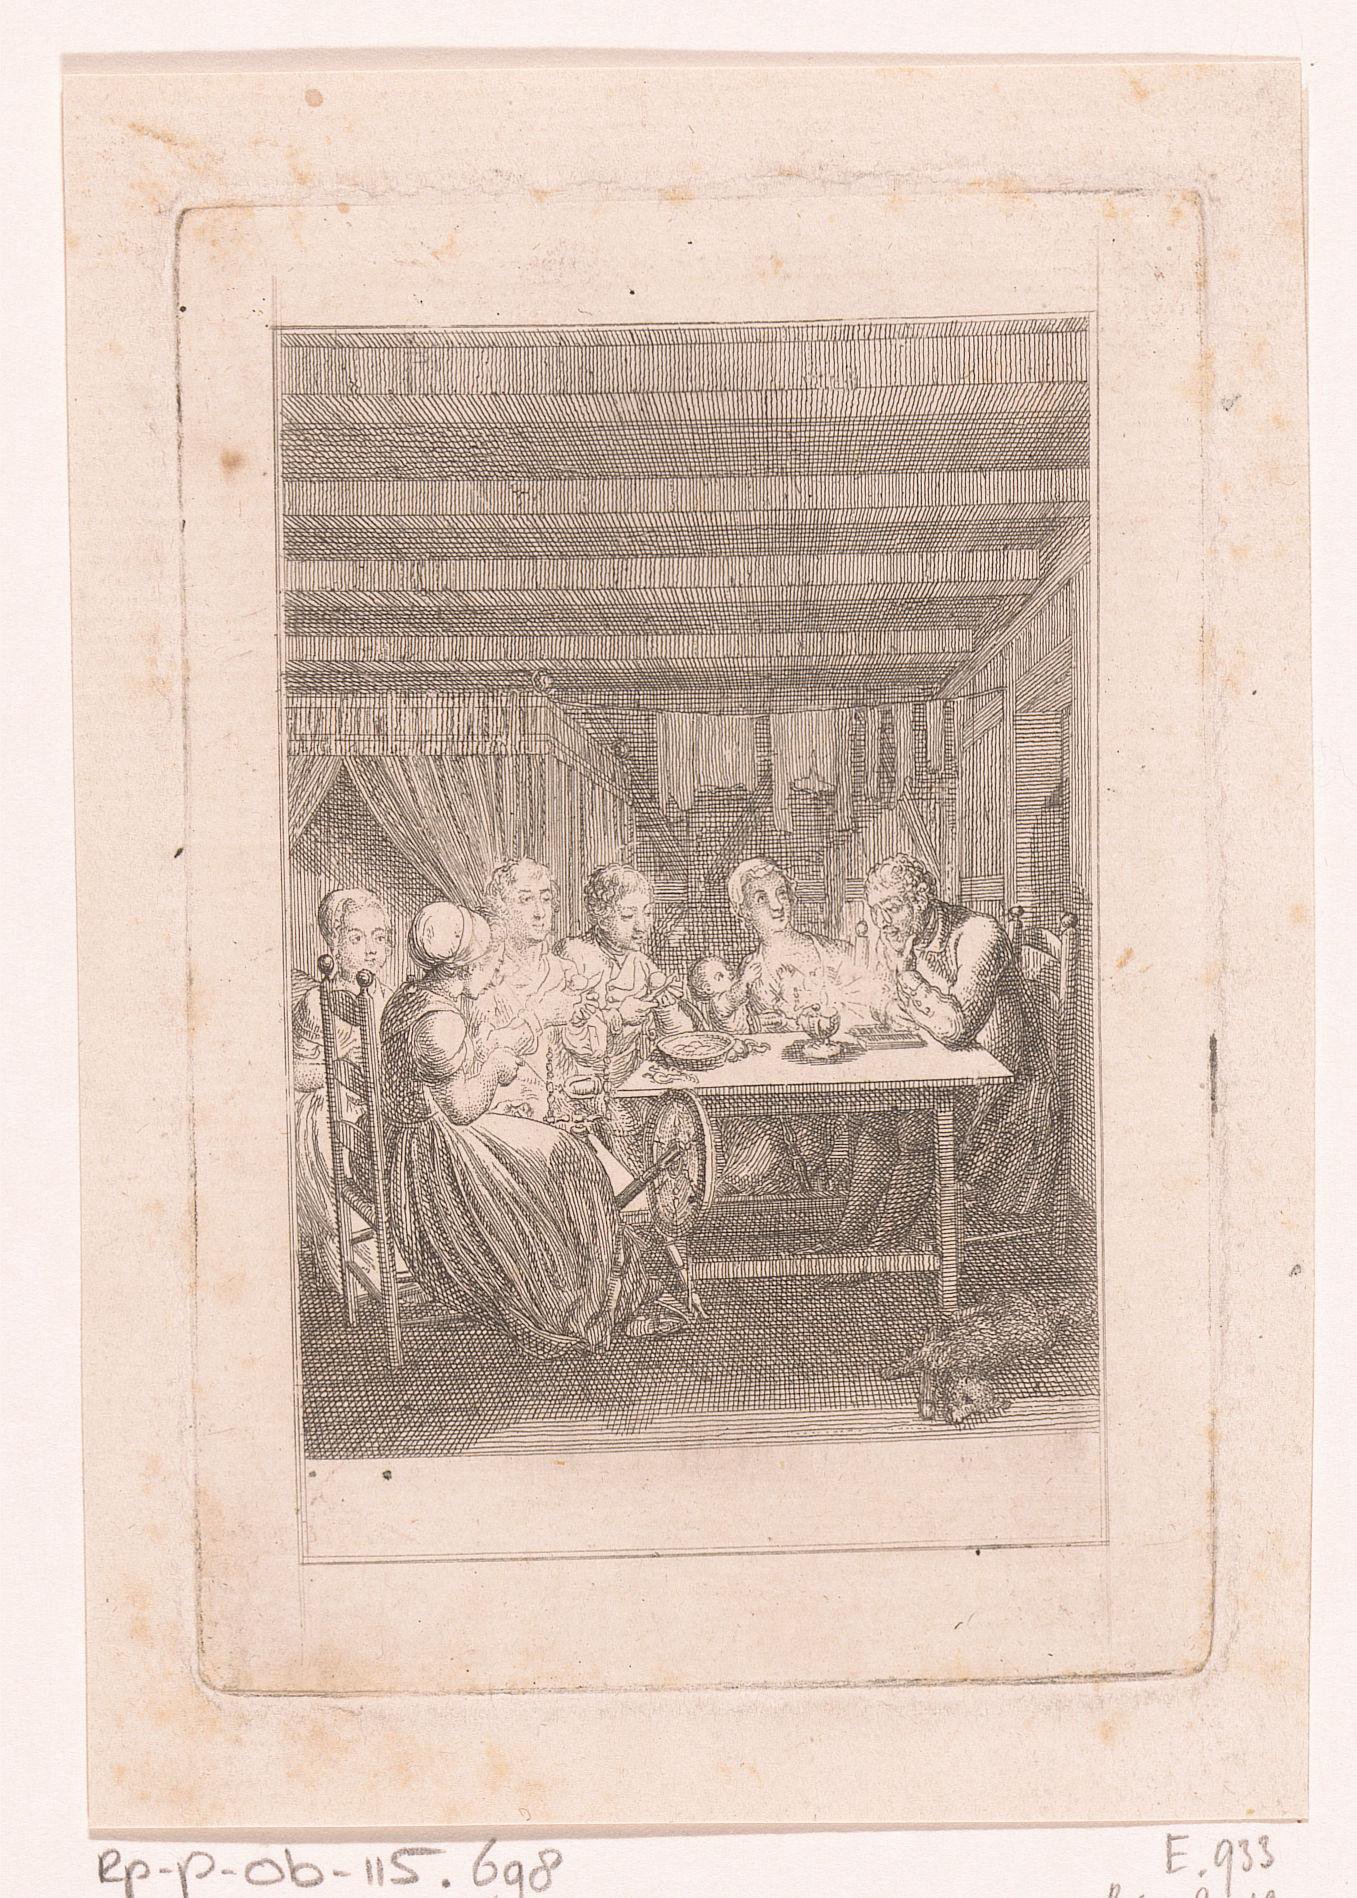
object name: print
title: Vader leest voor bij kaarslicht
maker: daniel nikolaus chodowiecki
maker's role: draughtsman, print maker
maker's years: 1726-1801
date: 1800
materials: paper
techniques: etching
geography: berlin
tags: candle, reading to somebody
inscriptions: collector's mark: Lugt 2228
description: Prent gebruikt voor: Salzmann, Christian Gotthilf. Taschenbuch zur Beförderung der Vaterlandsliebe. Auf das Jahr 1801 (...). Schnepfenthal: s.n., 1801.